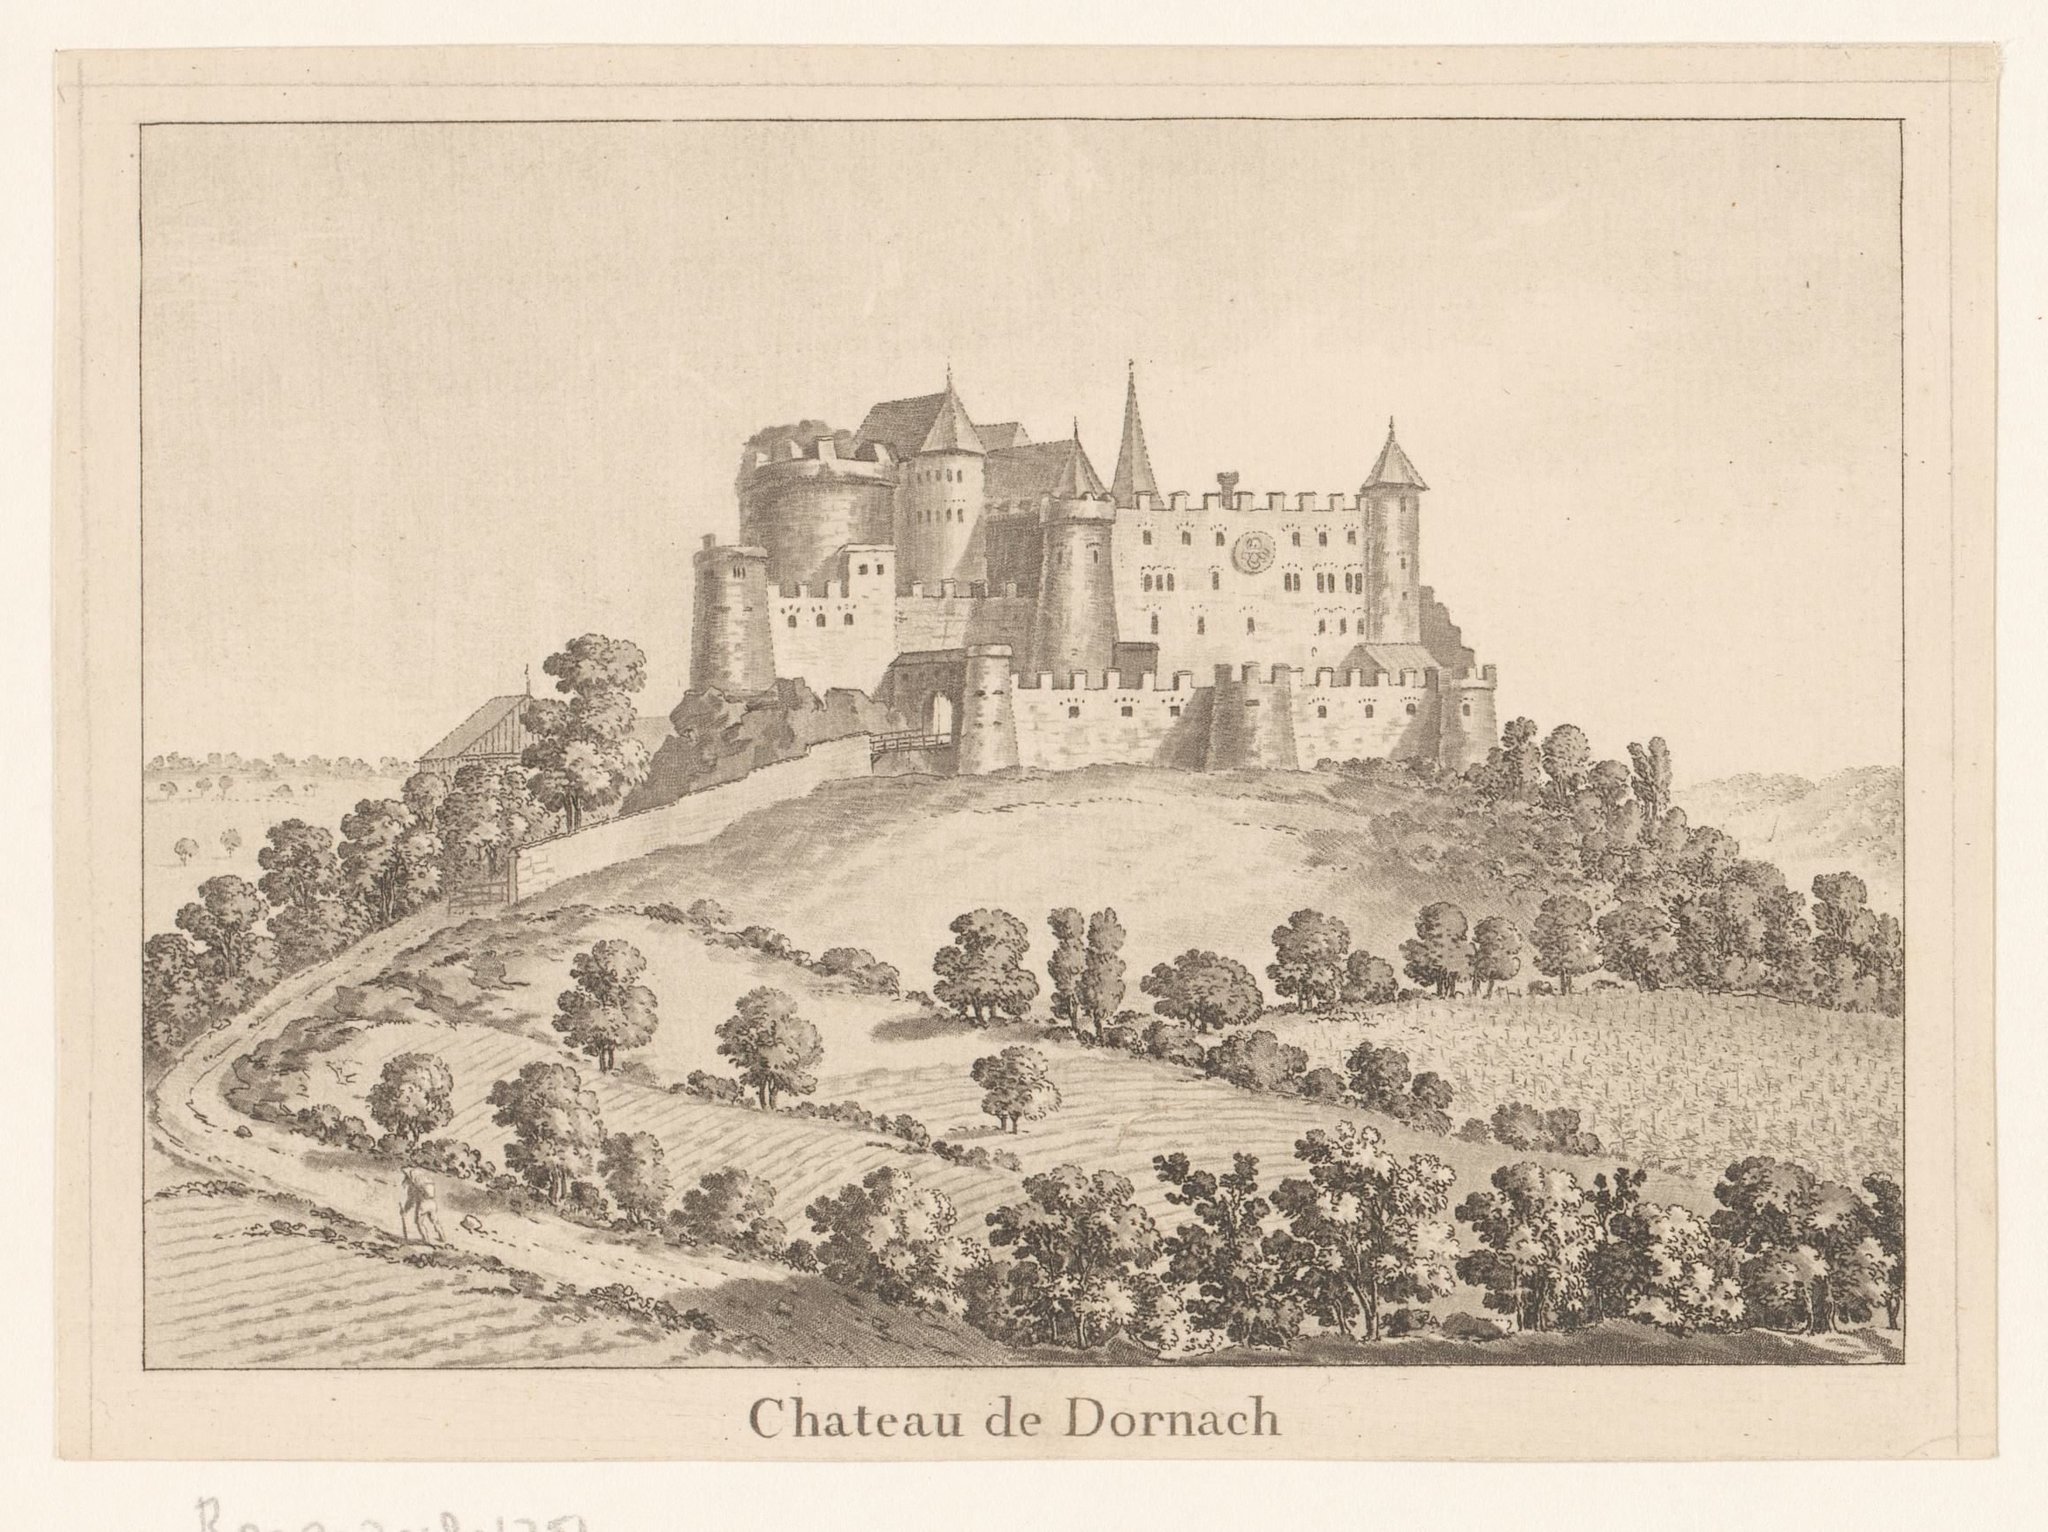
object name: print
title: Chateau de Dornach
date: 1810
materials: paper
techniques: aquatint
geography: amsterdam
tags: castle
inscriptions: collector's mark: Lugt 2228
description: Prent ook gebruikt in: Promenade Pittoresque dans l'évêché de bâle aux bords de la Birs (...). Amsterdam: T.B. Groebe, 1710.